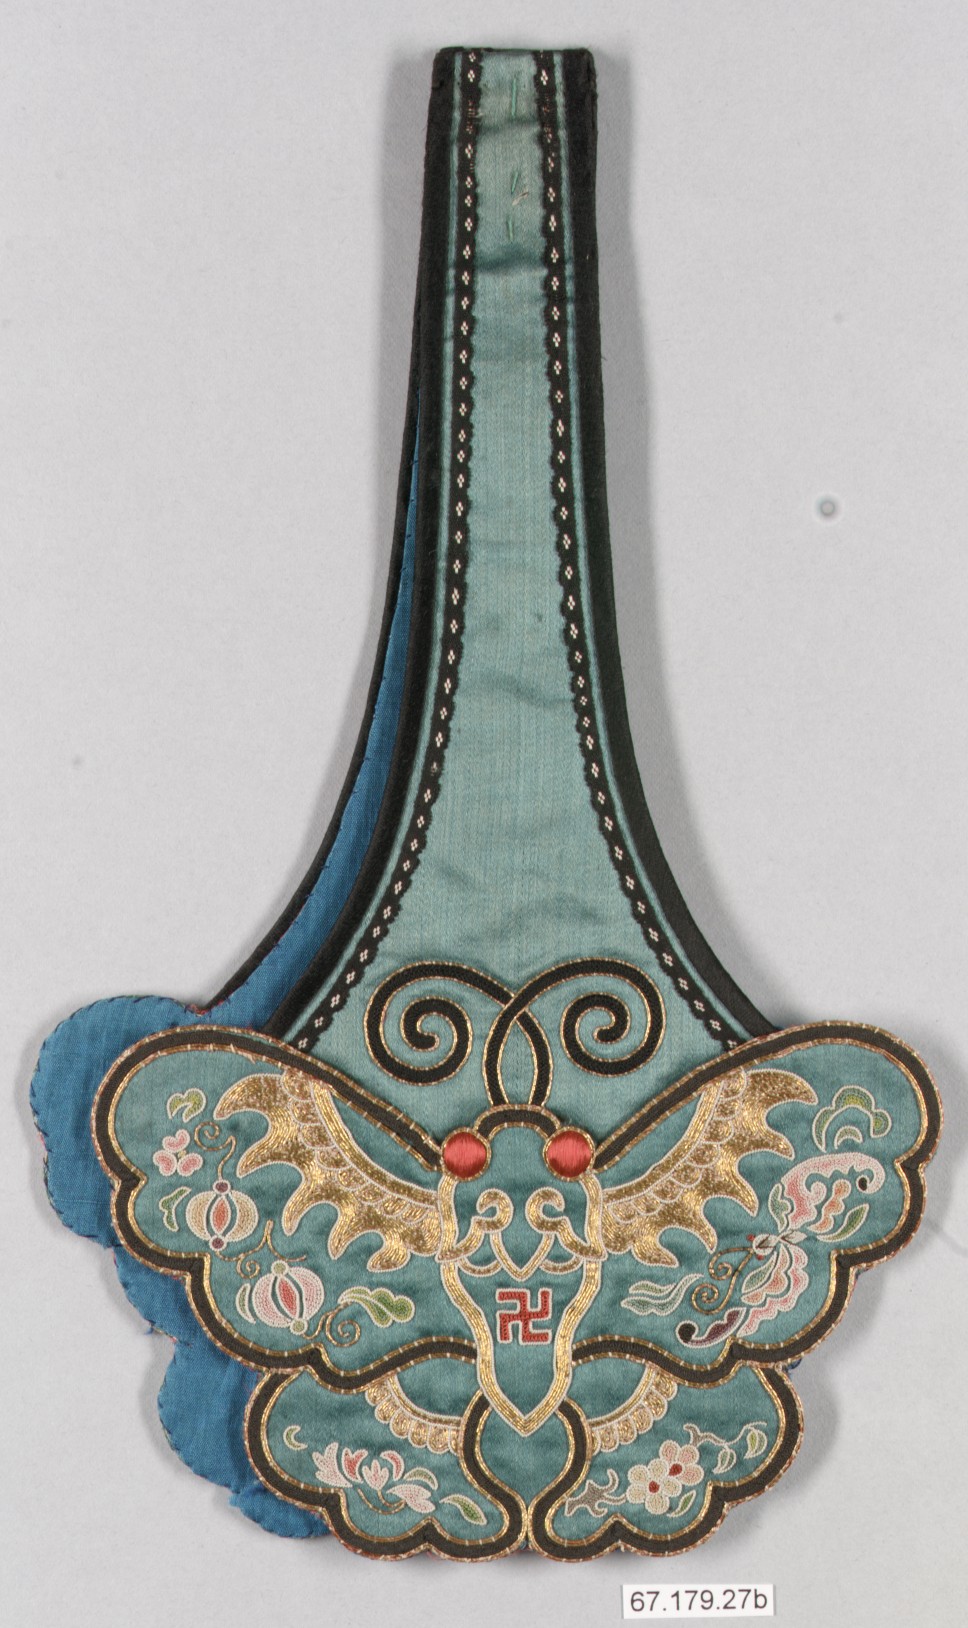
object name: streamer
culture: chinese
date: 1801-1900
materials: metal thread, silk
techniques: embroidery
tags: butterflies